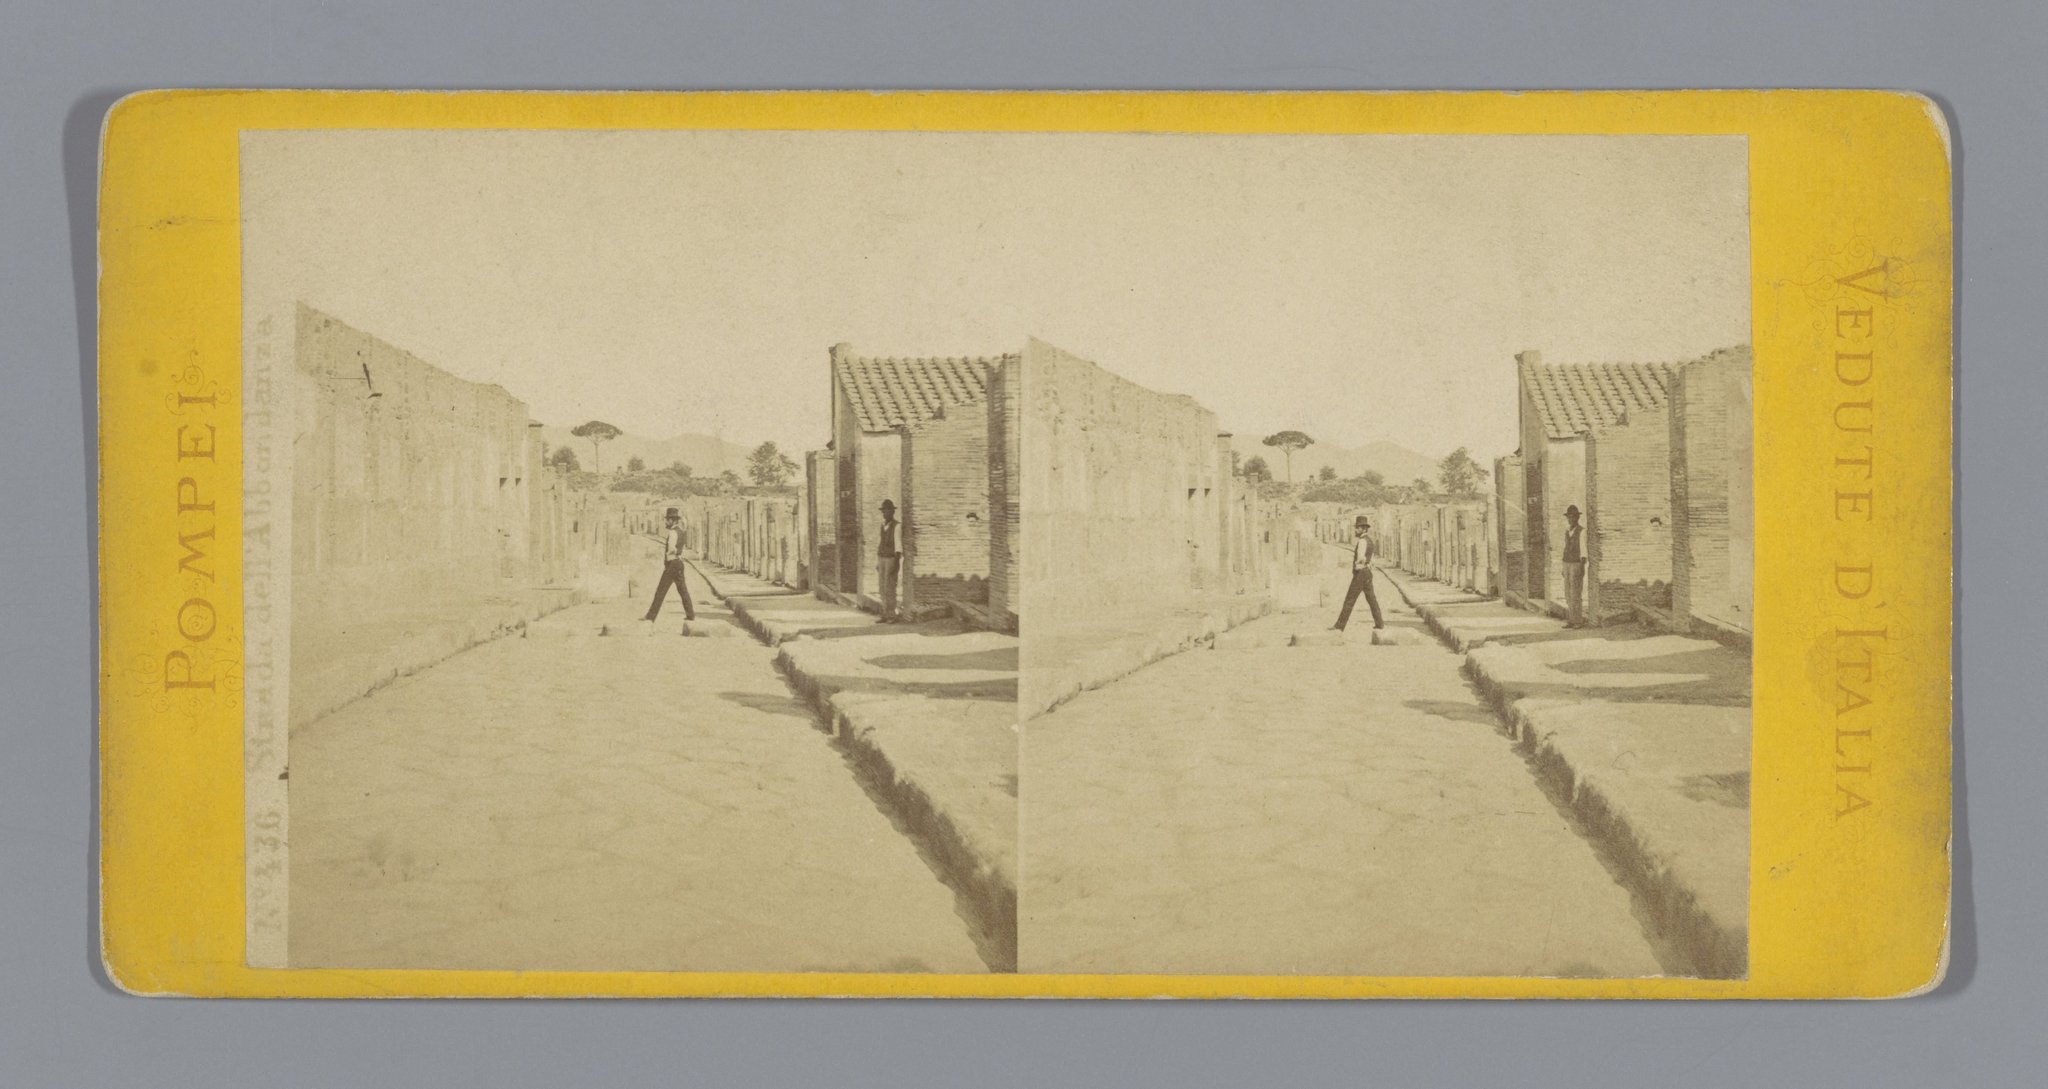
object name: stereograph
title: Via dell'Abbondanza te Pompeï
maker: Anonymous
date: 1850-1880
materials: cardboard, photographic support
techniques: albumen print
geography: via dell'abbondanza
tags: public road in village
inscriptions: inscription: ‘POMPEI VEDUTE D'ITALIA’, number: ‘No 436’